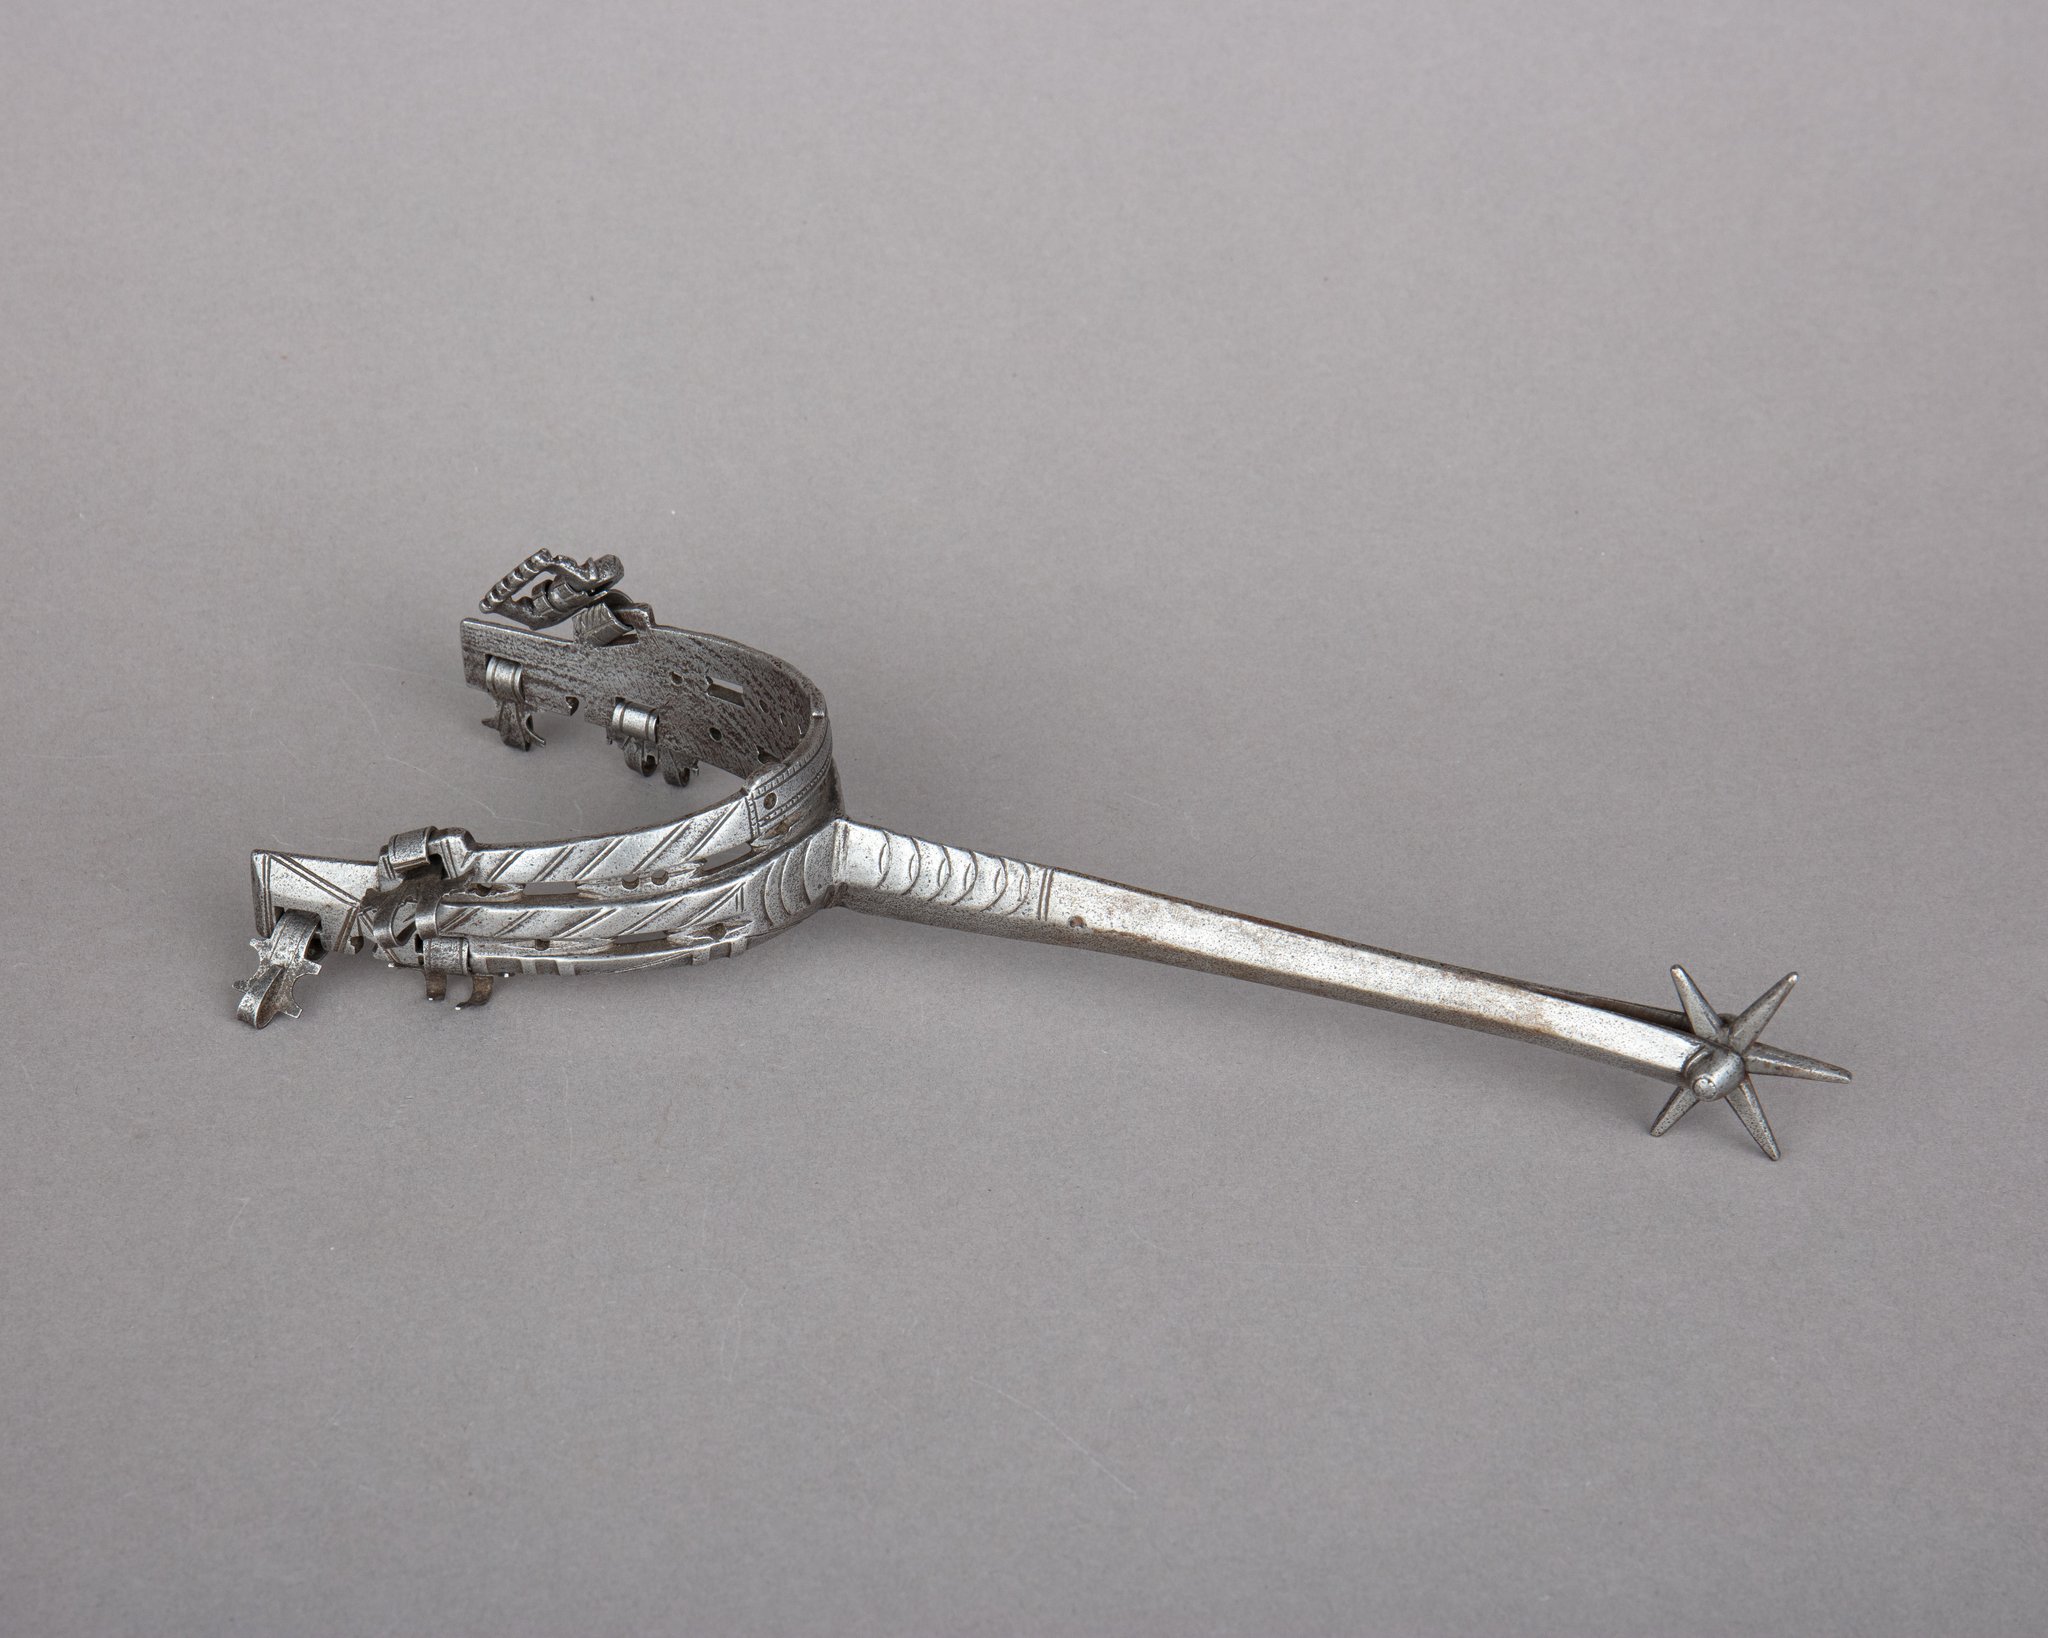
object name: spur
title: Rowel Spur (Right), in the Style of the 16th Century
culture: european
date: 1801-1900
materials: iron